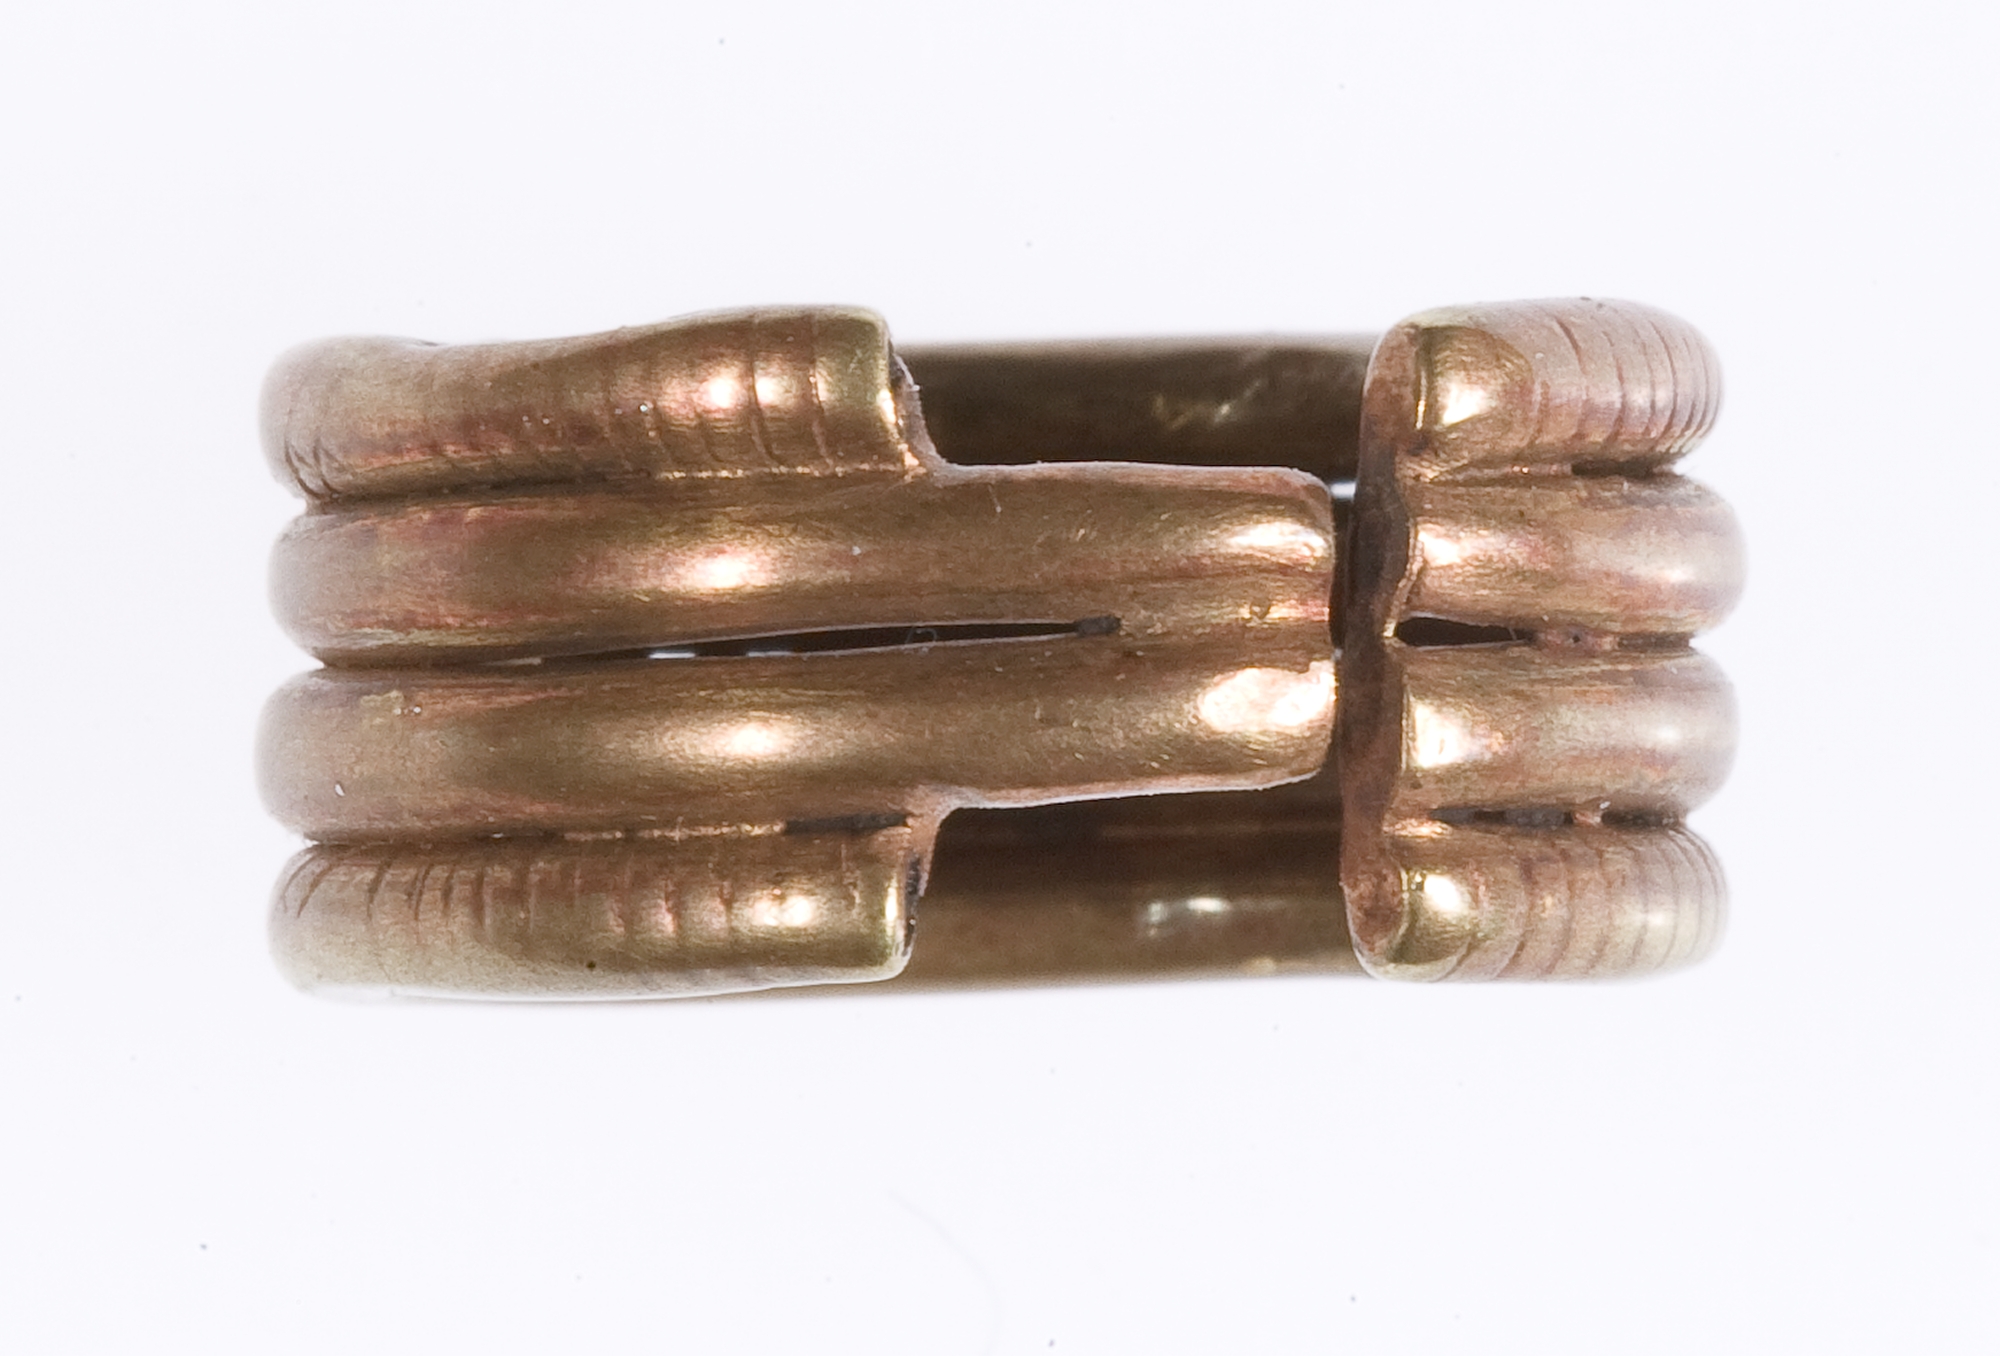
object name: earring, penannular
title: Penannular Earring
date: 1991-1450 BCE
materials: gold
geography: egypt